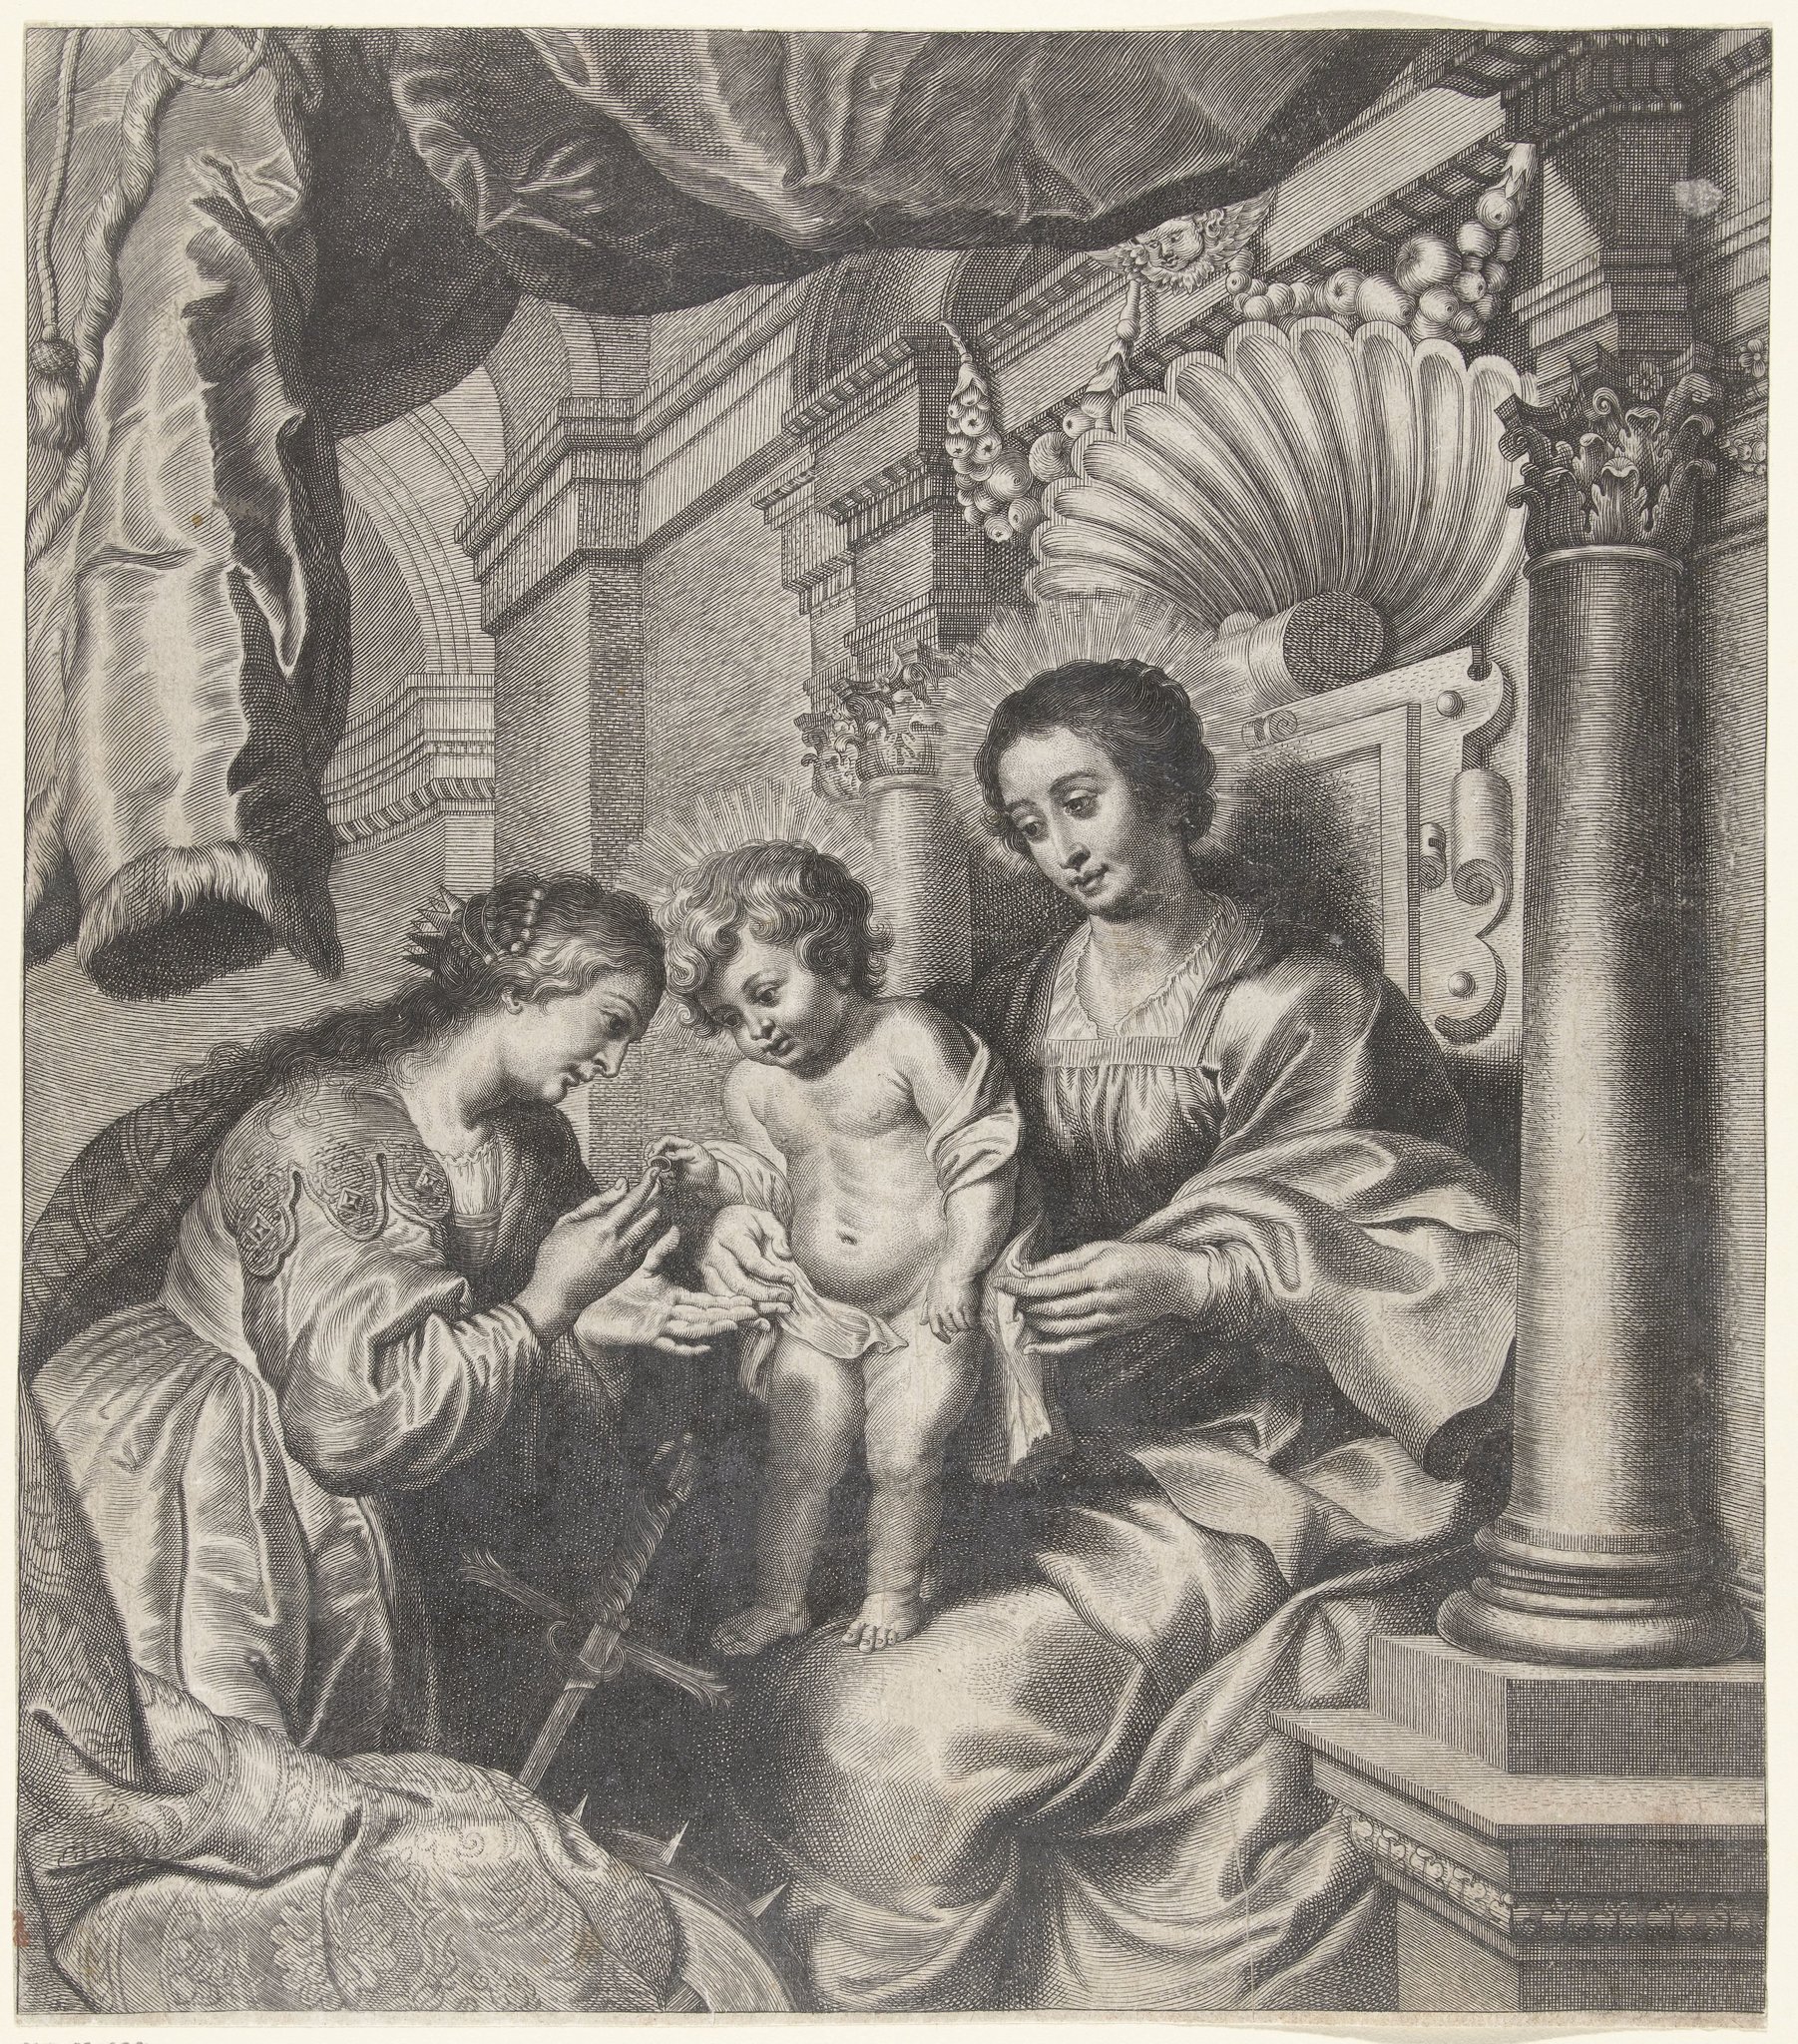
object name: print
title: Mystieke huwelijk van heilige Catharina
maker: boëtius adamsz. bolswert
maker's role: print maker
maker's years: 1580-1633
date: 1590-1633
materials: paper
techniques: engraving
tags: the mystic marriage of st. catherine of alexandria with the infant christ: the christ-child puts a ring on her finger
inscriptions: collector's mark: Lugt 240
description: Maria troont met het Christuskind op een monumentale troon. Christus schuift een ring aan de vinger van de heilige Catharina die voor hem knielt.